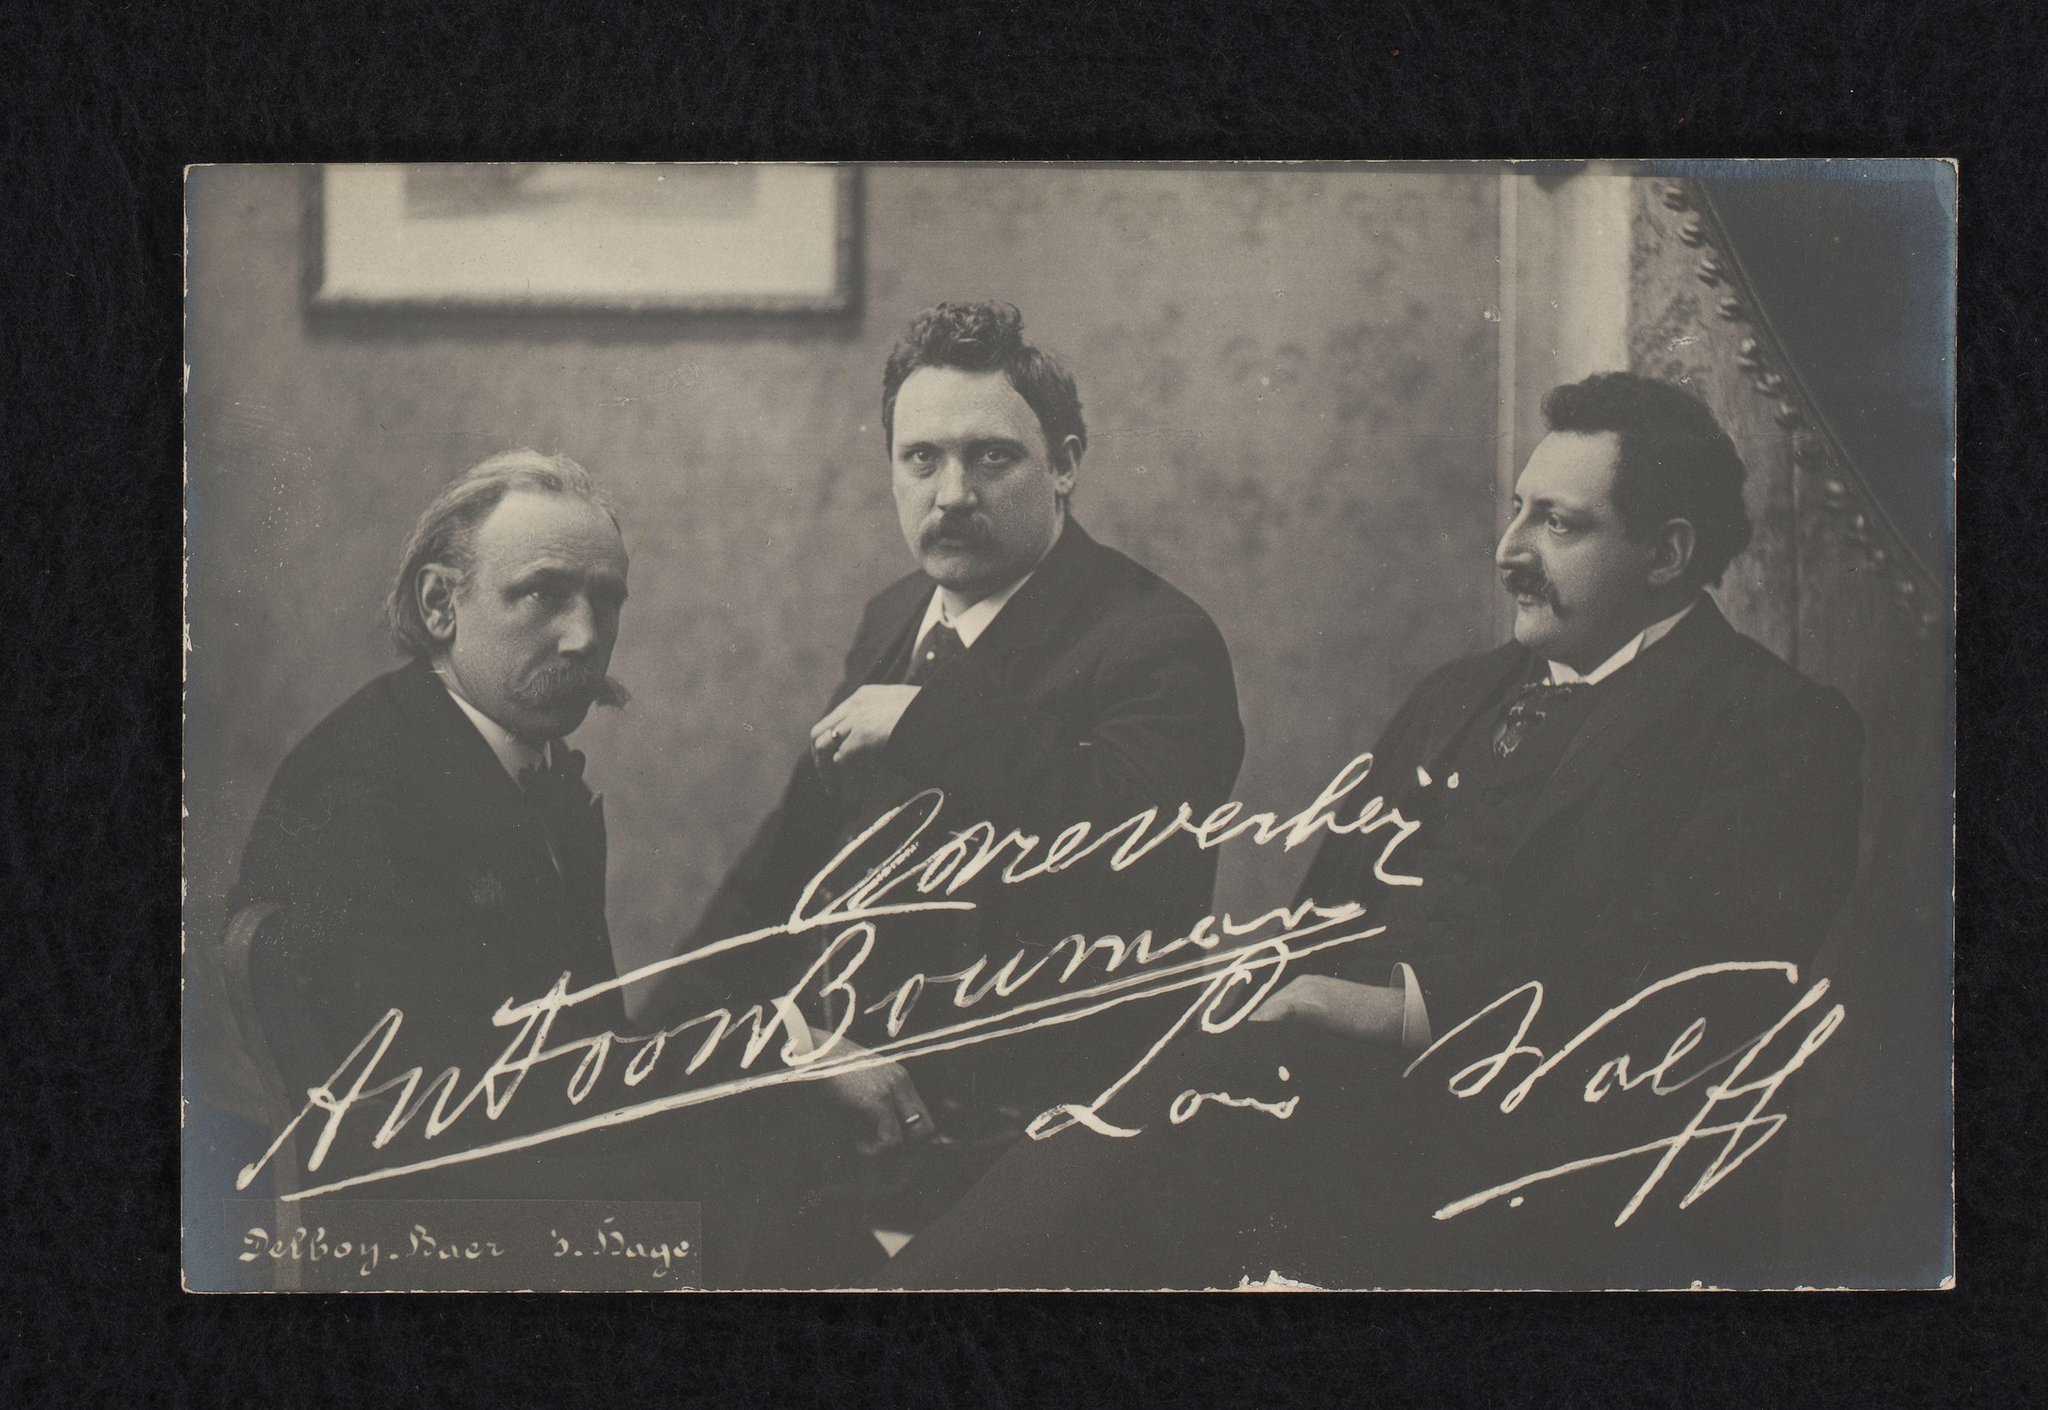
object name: album leaf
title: Portret van Antoon Bouman, Anton Verheij en Louis Wolff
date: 1900-1920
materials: photographic support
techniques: gelatin silver print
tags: rotterdam, den bosch, musician, adult man, historical persons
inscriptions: inscription: ‘Briefkaart/ aan’